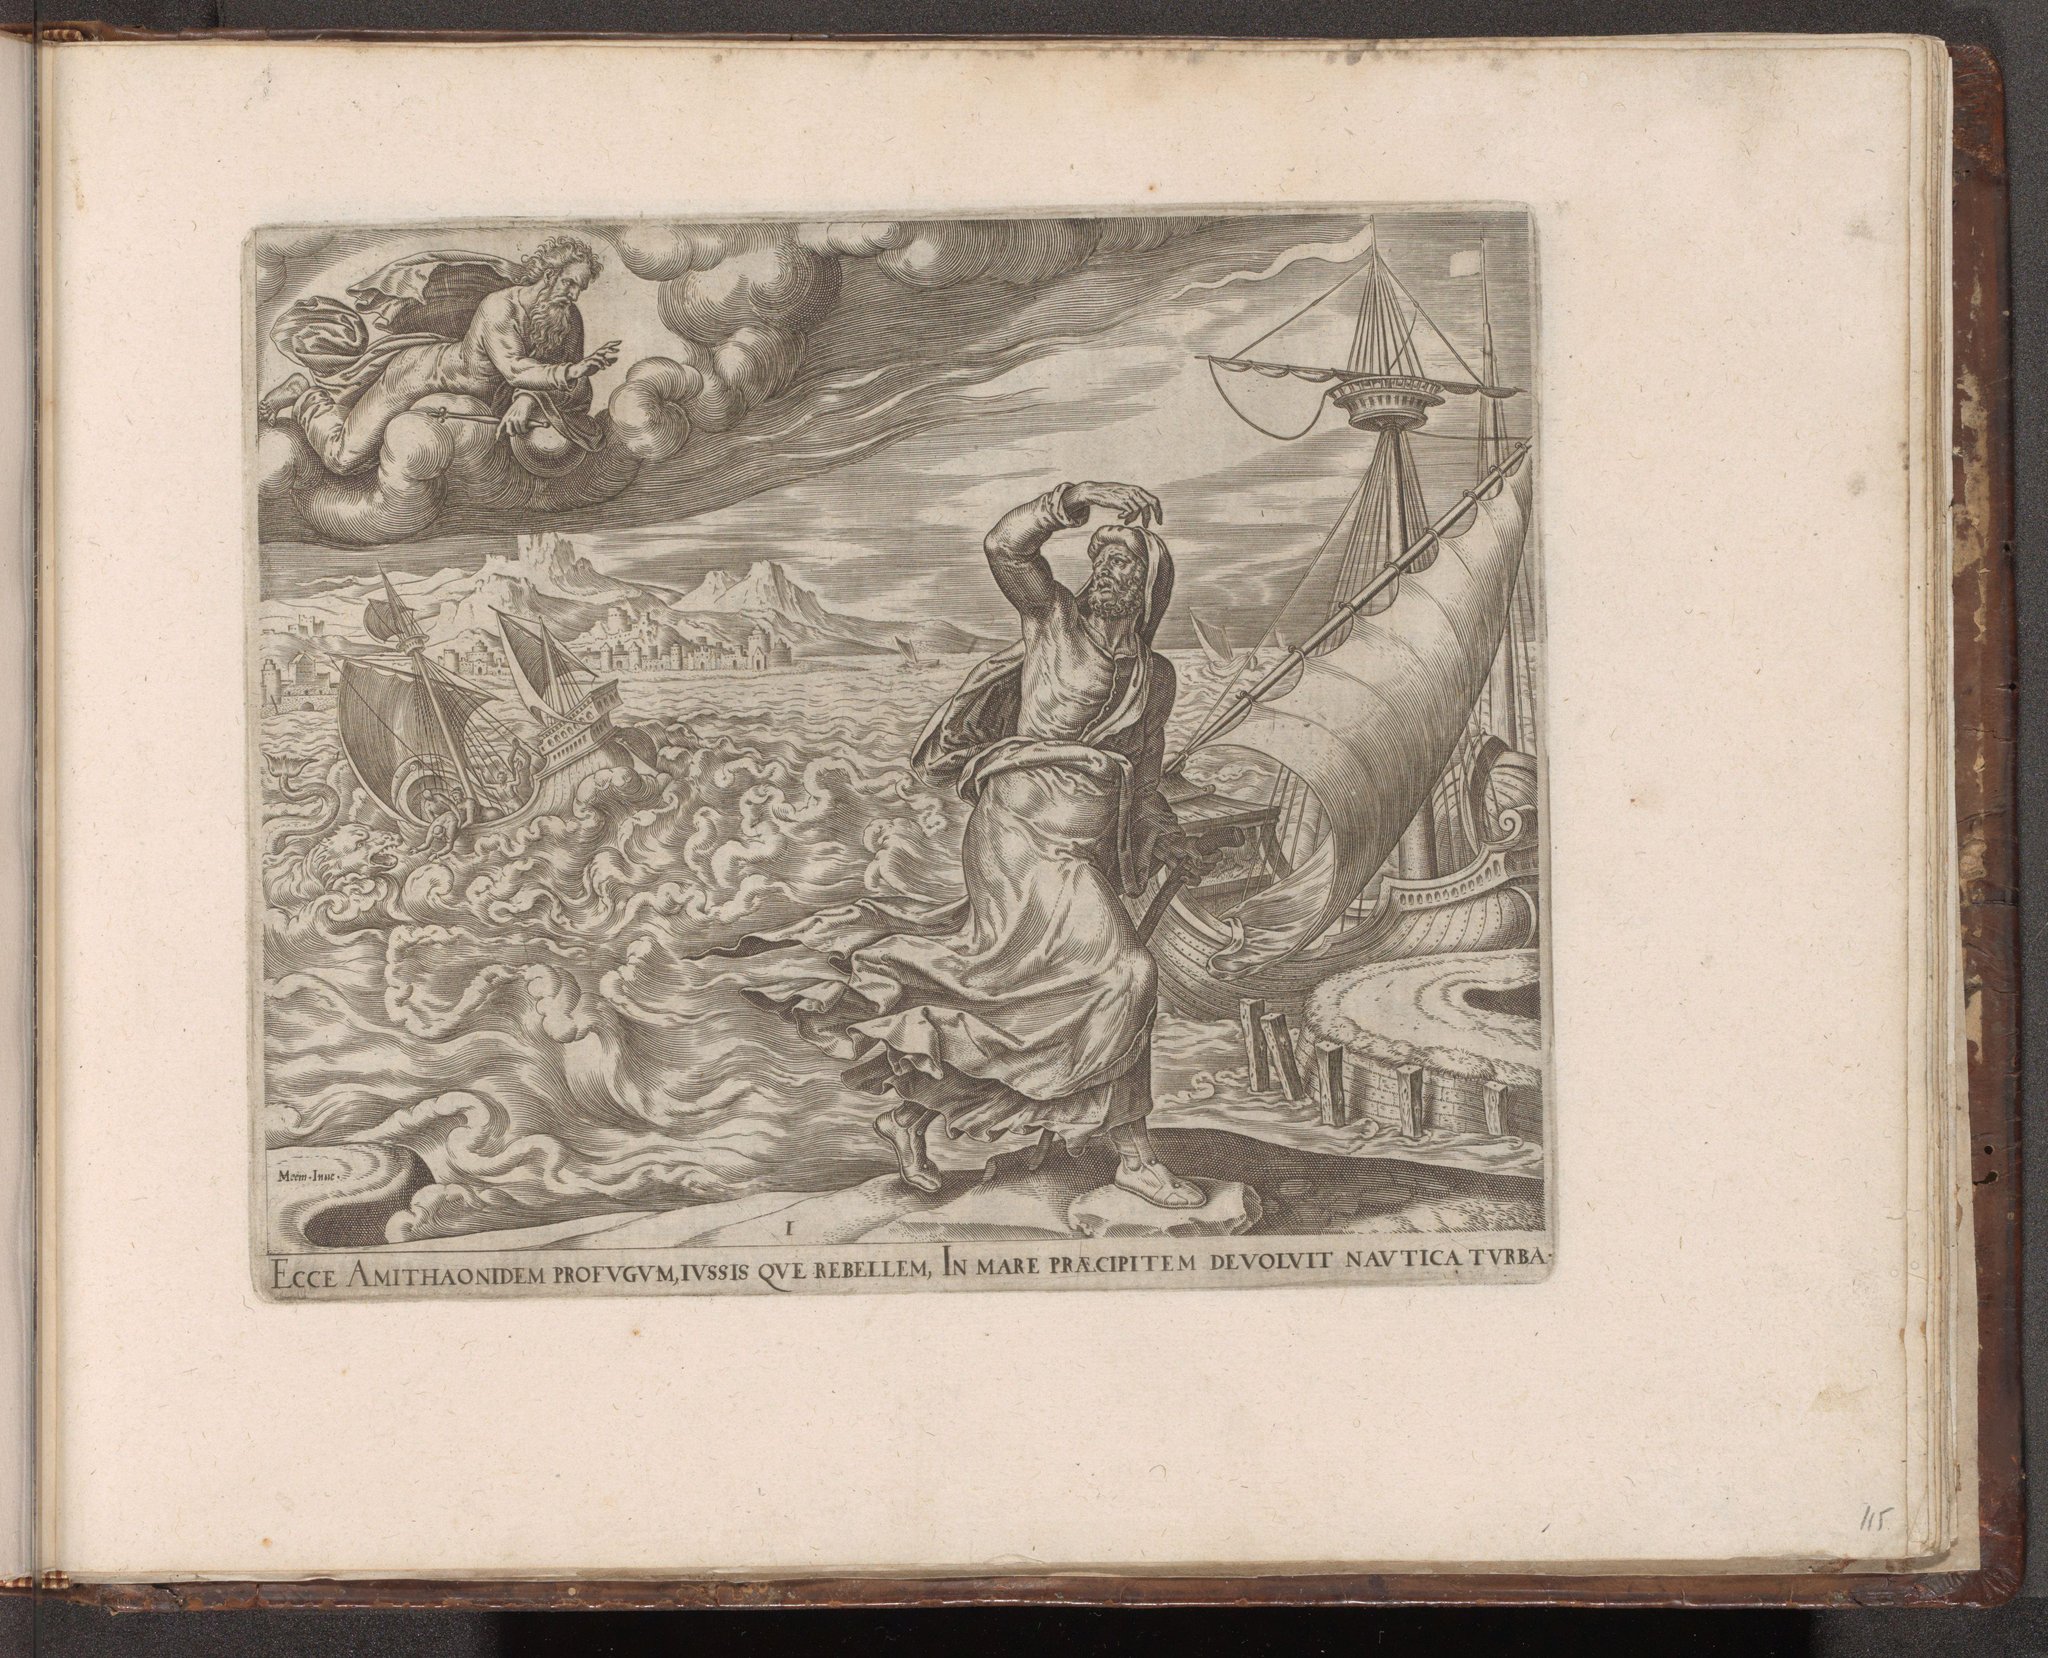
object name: album leaf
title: Thesaurus sacrarum historiaru[m] veteris testame[n]ti, elega[n]tissimis imaginibus expressu[m] excelle[n]tissimoru[m] in hac arte viroru[m] opera: nu[n]c primu[m] in luce[m] editus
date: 1566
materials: paper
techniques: engraving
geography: antwerp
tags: jonah's call and disobedience (jonah 1), jonah is sent by god to nineveh to preach to its sinful citizens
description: Jona staat aan de kustlijn en kijkt naar God die op een wolk ligt. God geeft Jona de opdracht naar Nineve te gaan. Aan de kademuur ligt het schip waarmee Jona vlucht. Op het water is te zien hoe Jona later overboord wordt gegooid en door een vis wordt opgeslokt. Onder de voorstelling een verklarende tekst in het Latijn. Prent maakt deel uit van een album.